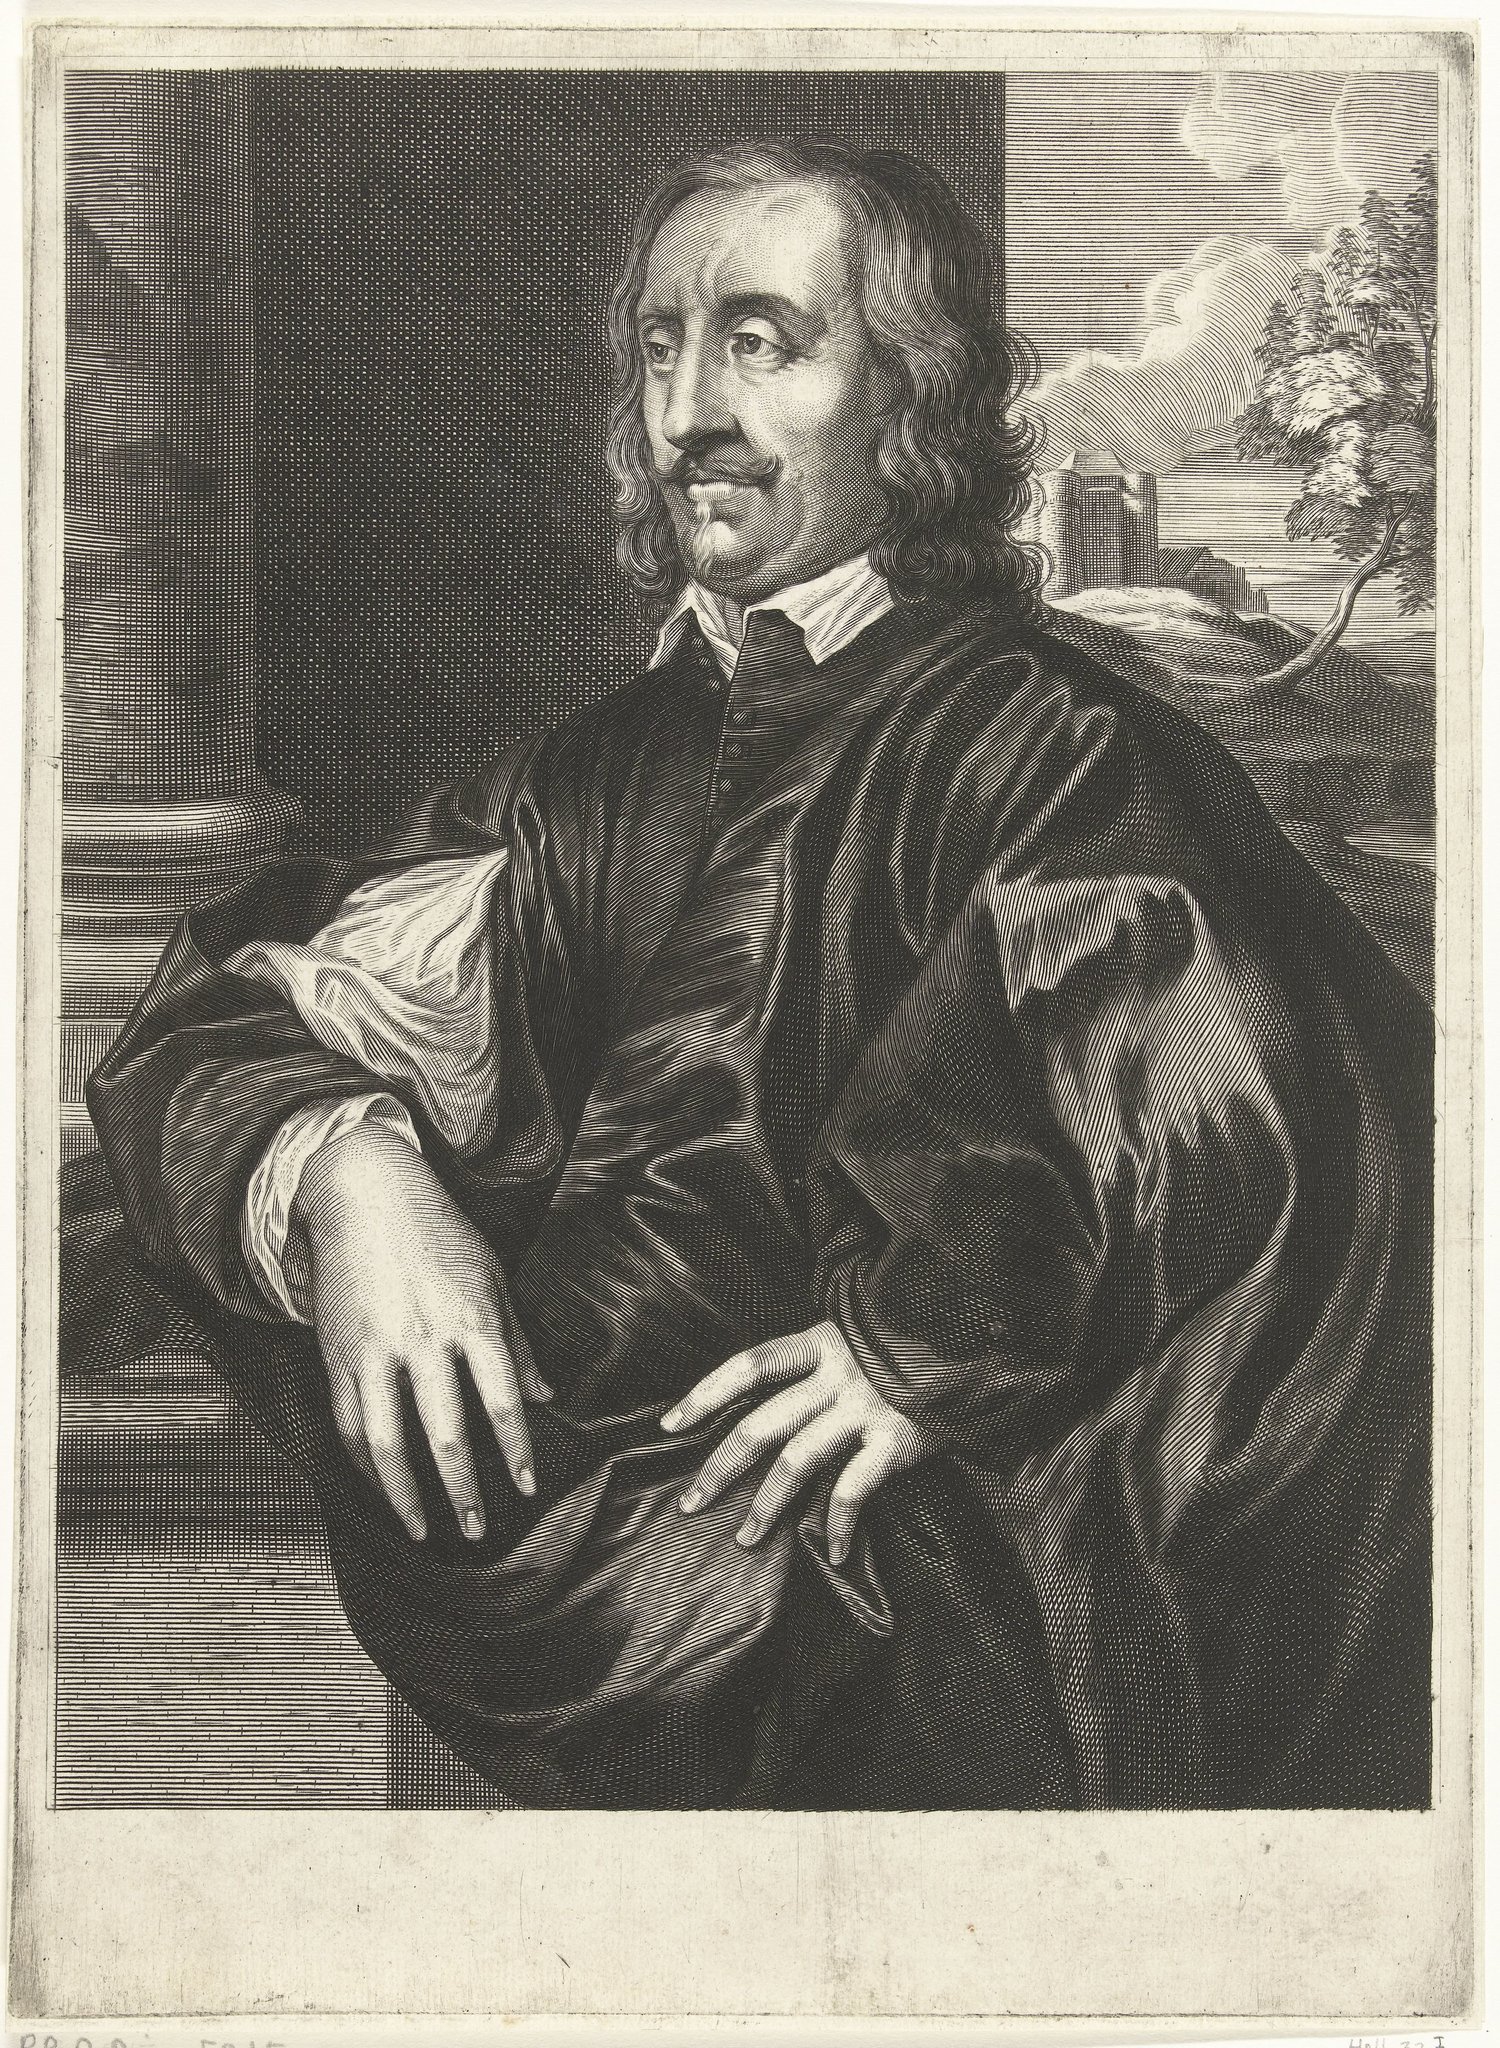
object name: print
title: Portret van Theodor Rogiers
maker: petrus clouwet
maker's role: draughtsman, print maker, publisher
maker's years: 1629-1670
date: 1639-1670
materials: paper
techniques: engraving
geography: antwerp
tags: goldsmith, theodoor rogiers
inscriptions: collector's mark: Lugt 240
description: Portret van Theodor Rogiers, een Antwerpse goudsmid. Buste naar links.